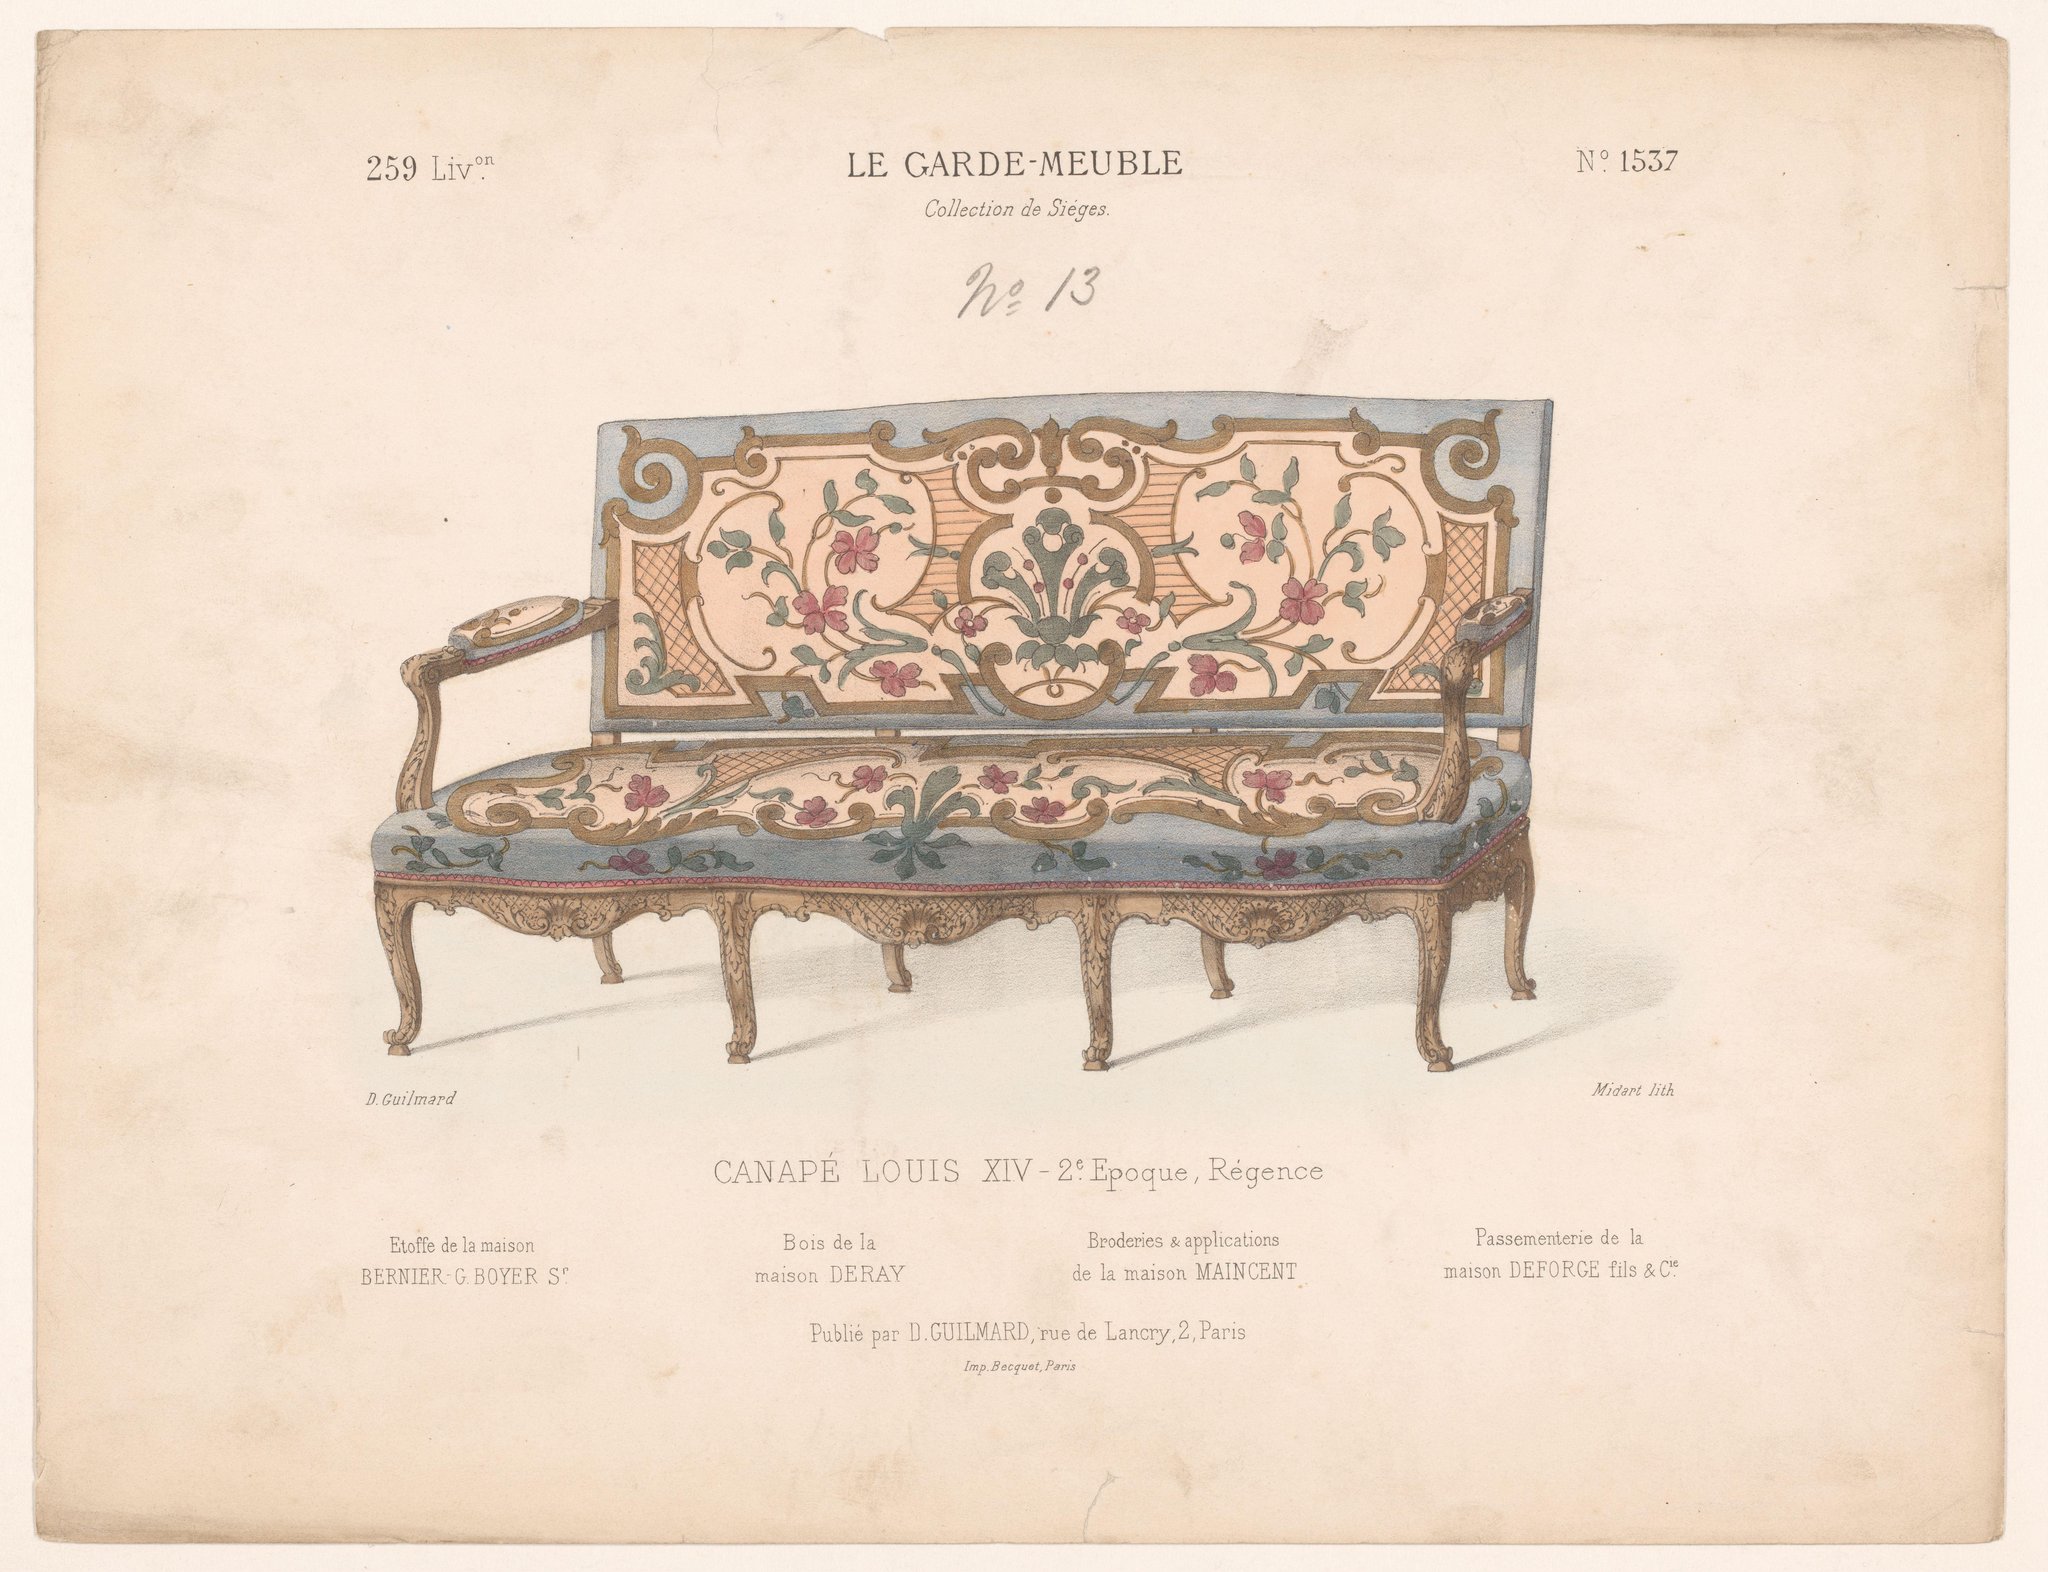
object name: print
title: Le garde-meuble / Collection de Sièges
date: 1839-1885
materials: paper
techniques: hand coloring, lithograph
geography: paris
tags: seating furniture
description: Ieder Livraison in de serie Le Garde-Meuble bevat negen platen: drie 'sièges' (zitmeubels), drie 'meubles' (diverse meubels zoals tafels en kasten) en drie 'tentures' (gordijnen en draperieën).